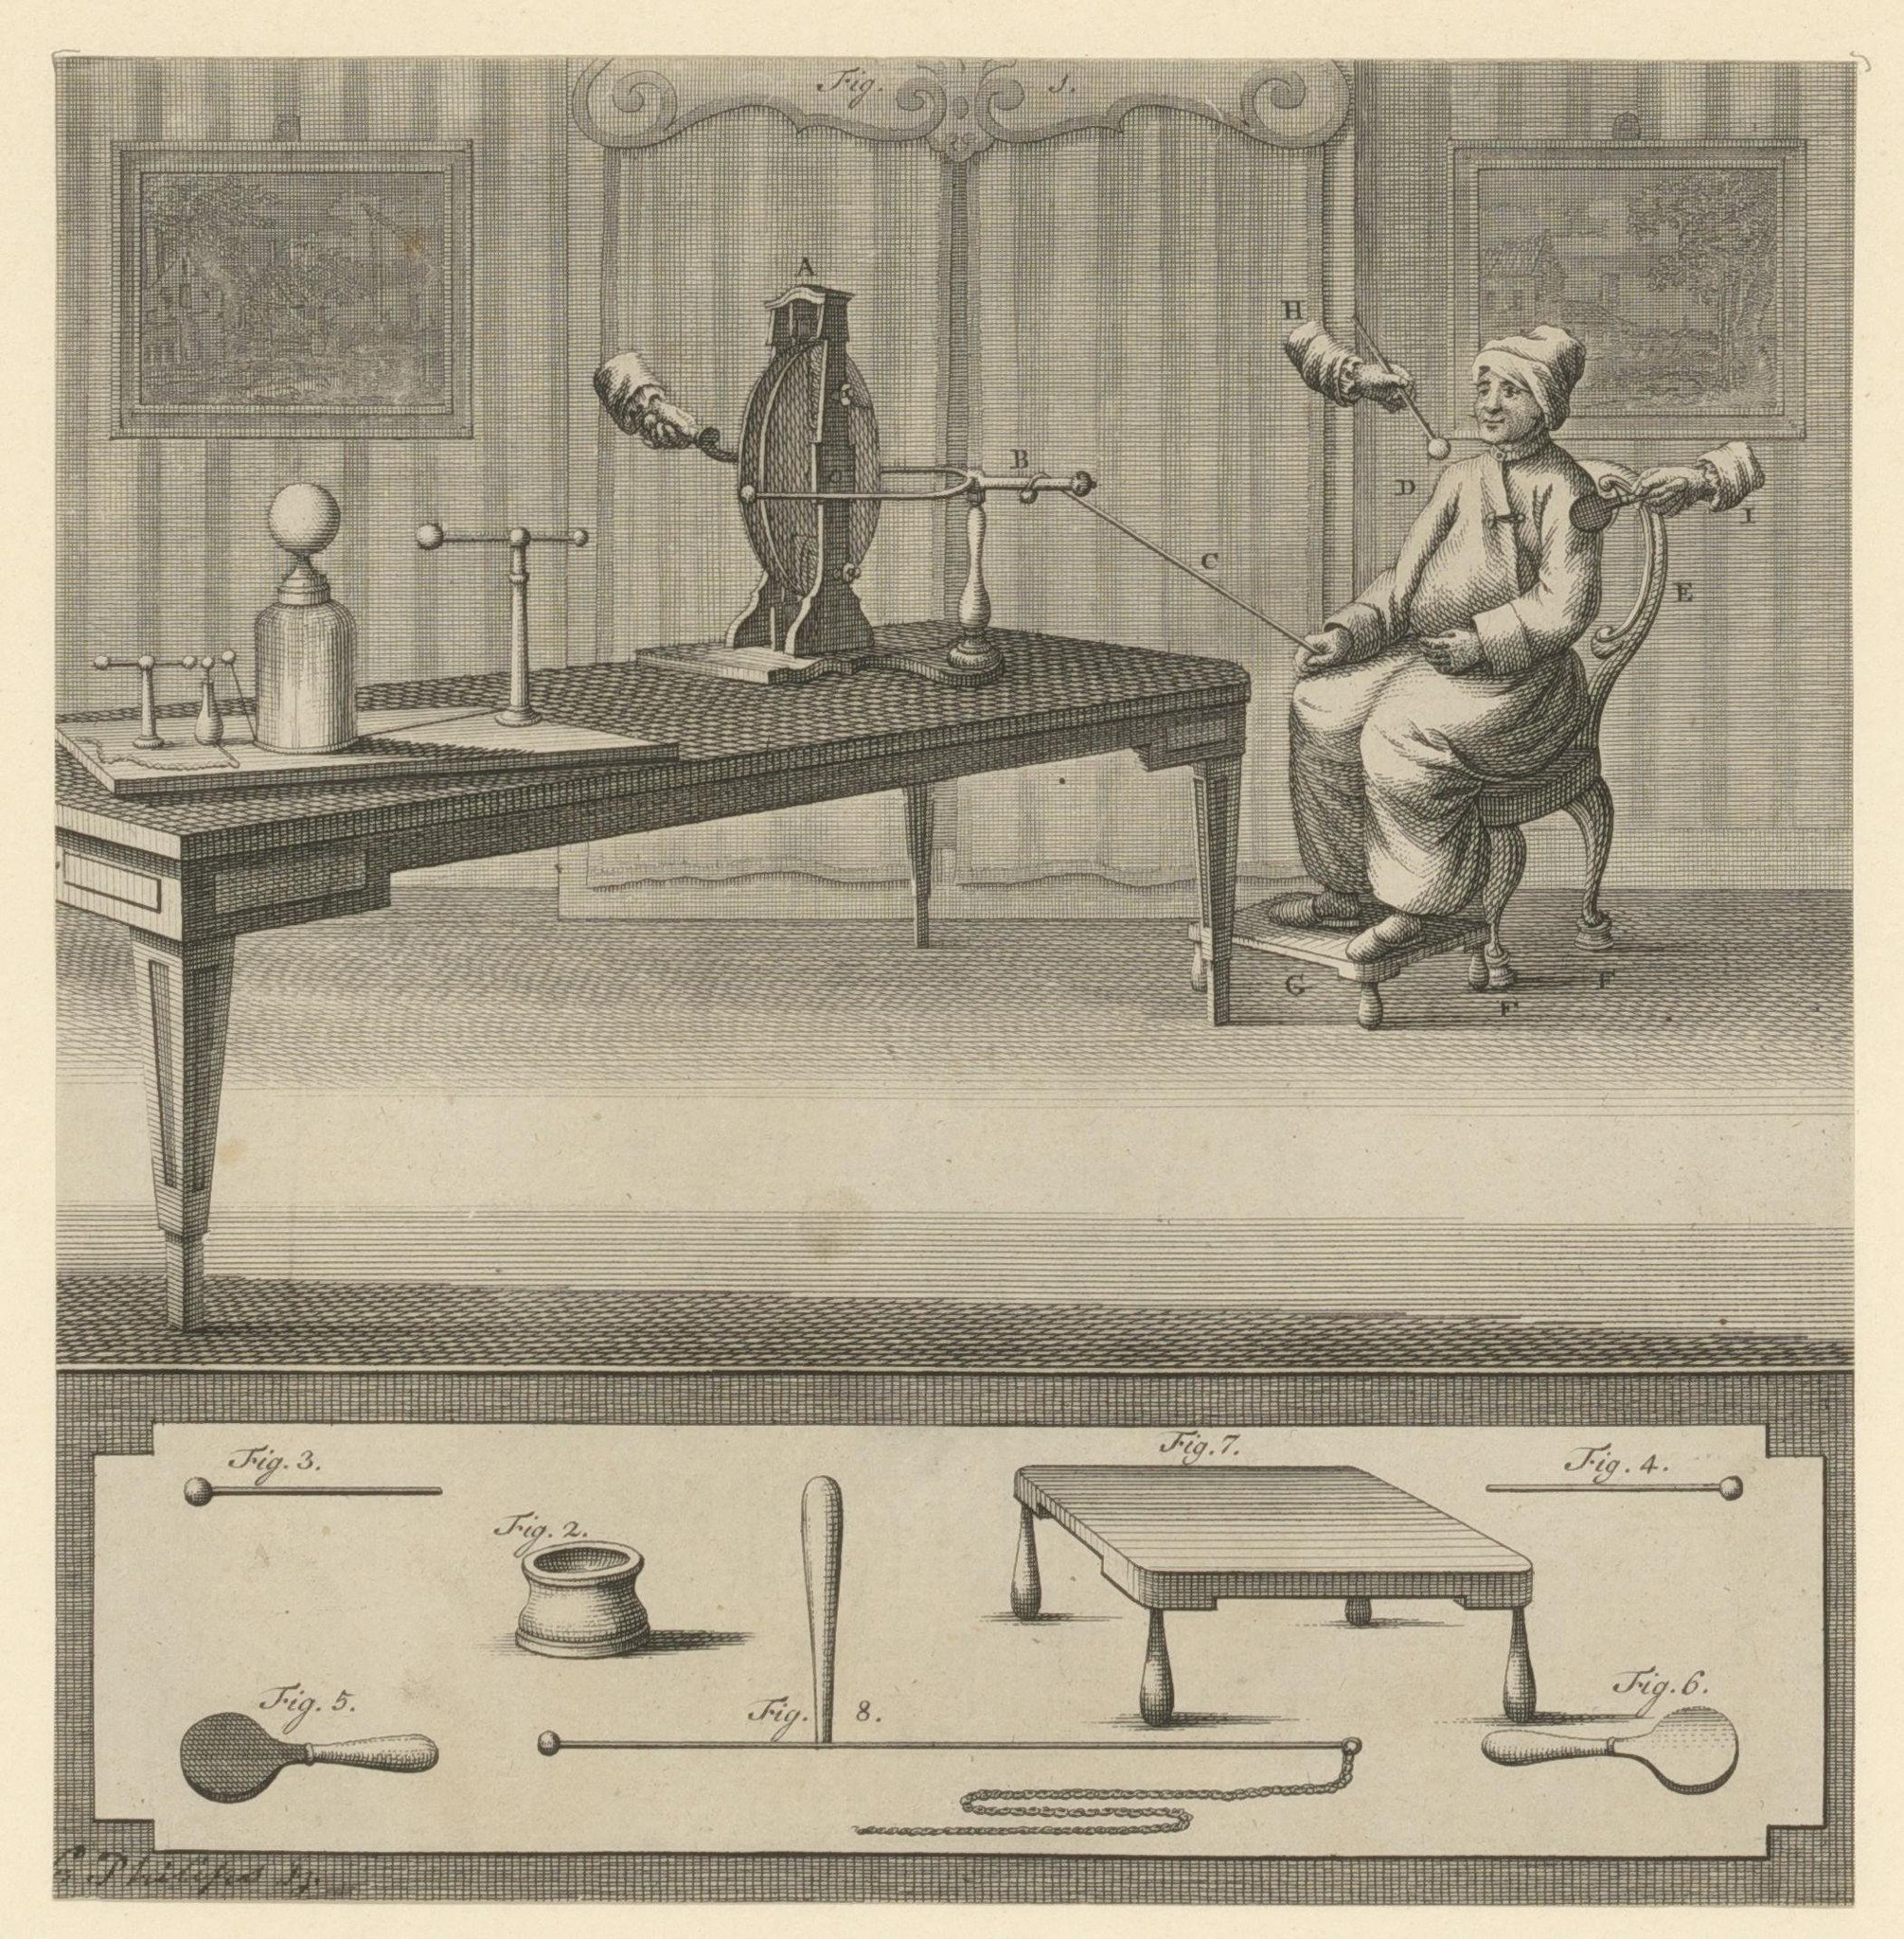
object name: print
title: Studeerkamer van Johan Christophorus Ludeman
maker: Anonymous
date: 1714-1799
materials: paper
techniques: engraving, etching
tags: amsterdam, quack, charlatan, mountebank, 'saltimbanco', study; 'studiolo'; library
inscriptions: collector's mark: Lugt 1641, stamp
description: Studeerkamer van Johan Christophorus Ludeman. Ludeman zit op een stoel bij een lange tafel. Op de tafel staat een verticale draaischijf. Een zwevende hand draait aan de schijf. Twee zwevende handen houden attributen bij Ludeman. Onderaan diverse attributen die Ludeman gebruikte tijdens zijn werkzaamheden. Onderwerpsrubrieken binnen de Atlas Zeden en Gewoonten: Onderwijs en Wetenschappen, Alchemisten.